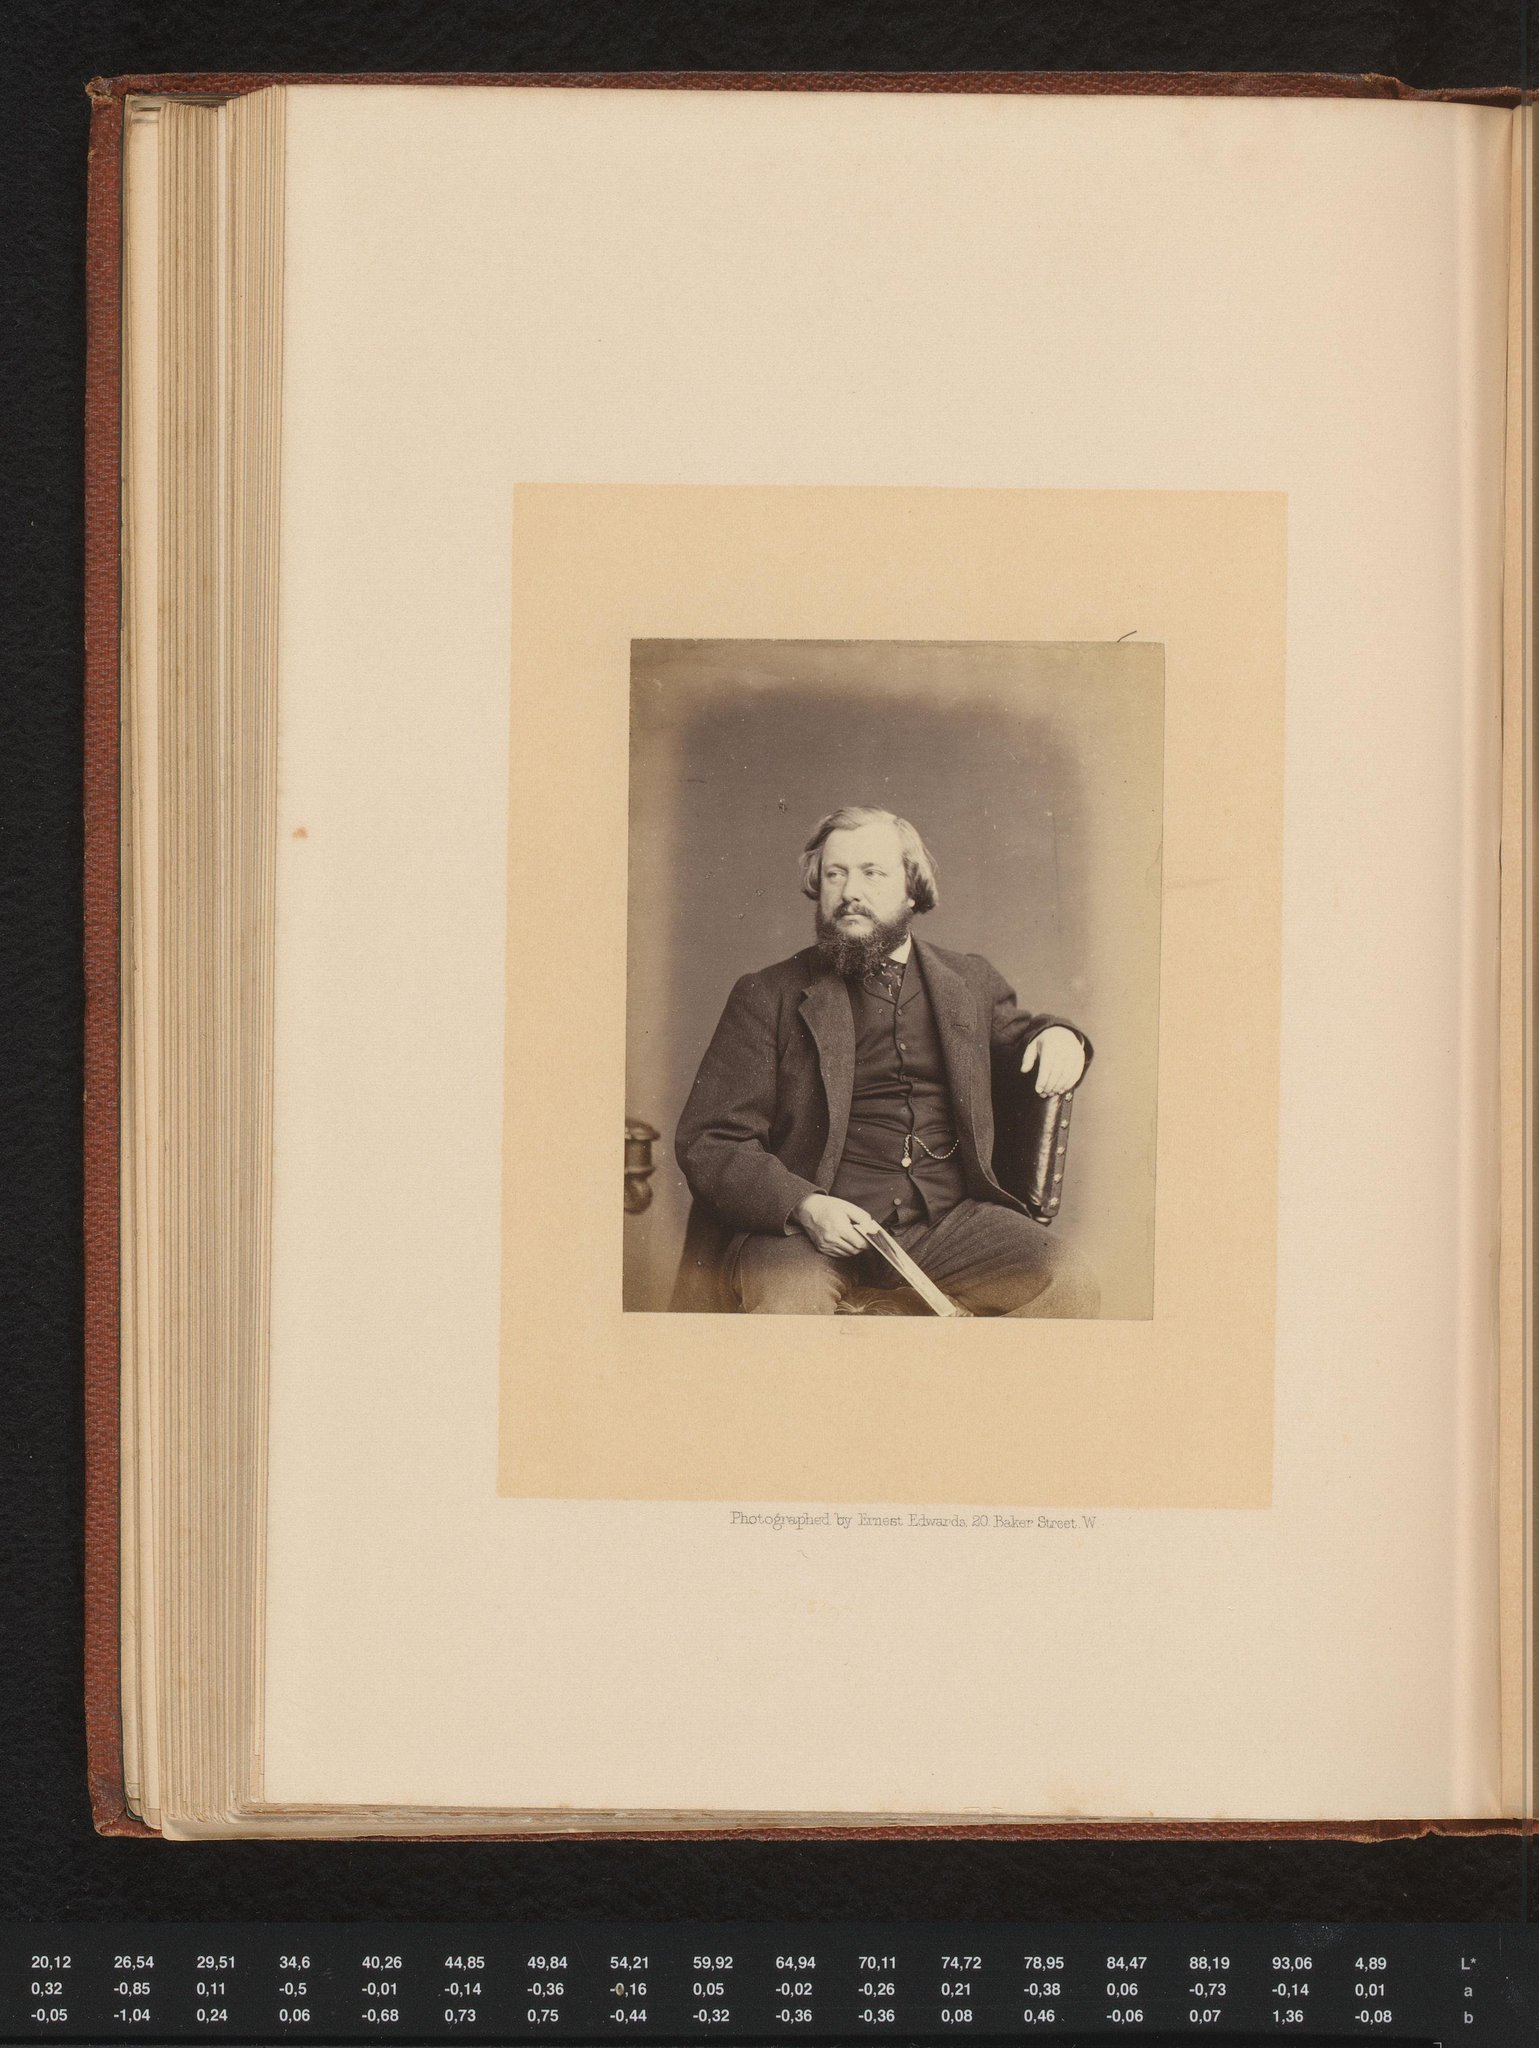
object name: page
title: Portret van de journalist en romanschrijver Shirley Brooks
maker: ernest edwards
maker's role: fotograaf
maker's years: 1837-1903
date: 1861-1866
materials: paper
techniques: albumen print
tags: portrait of a writer